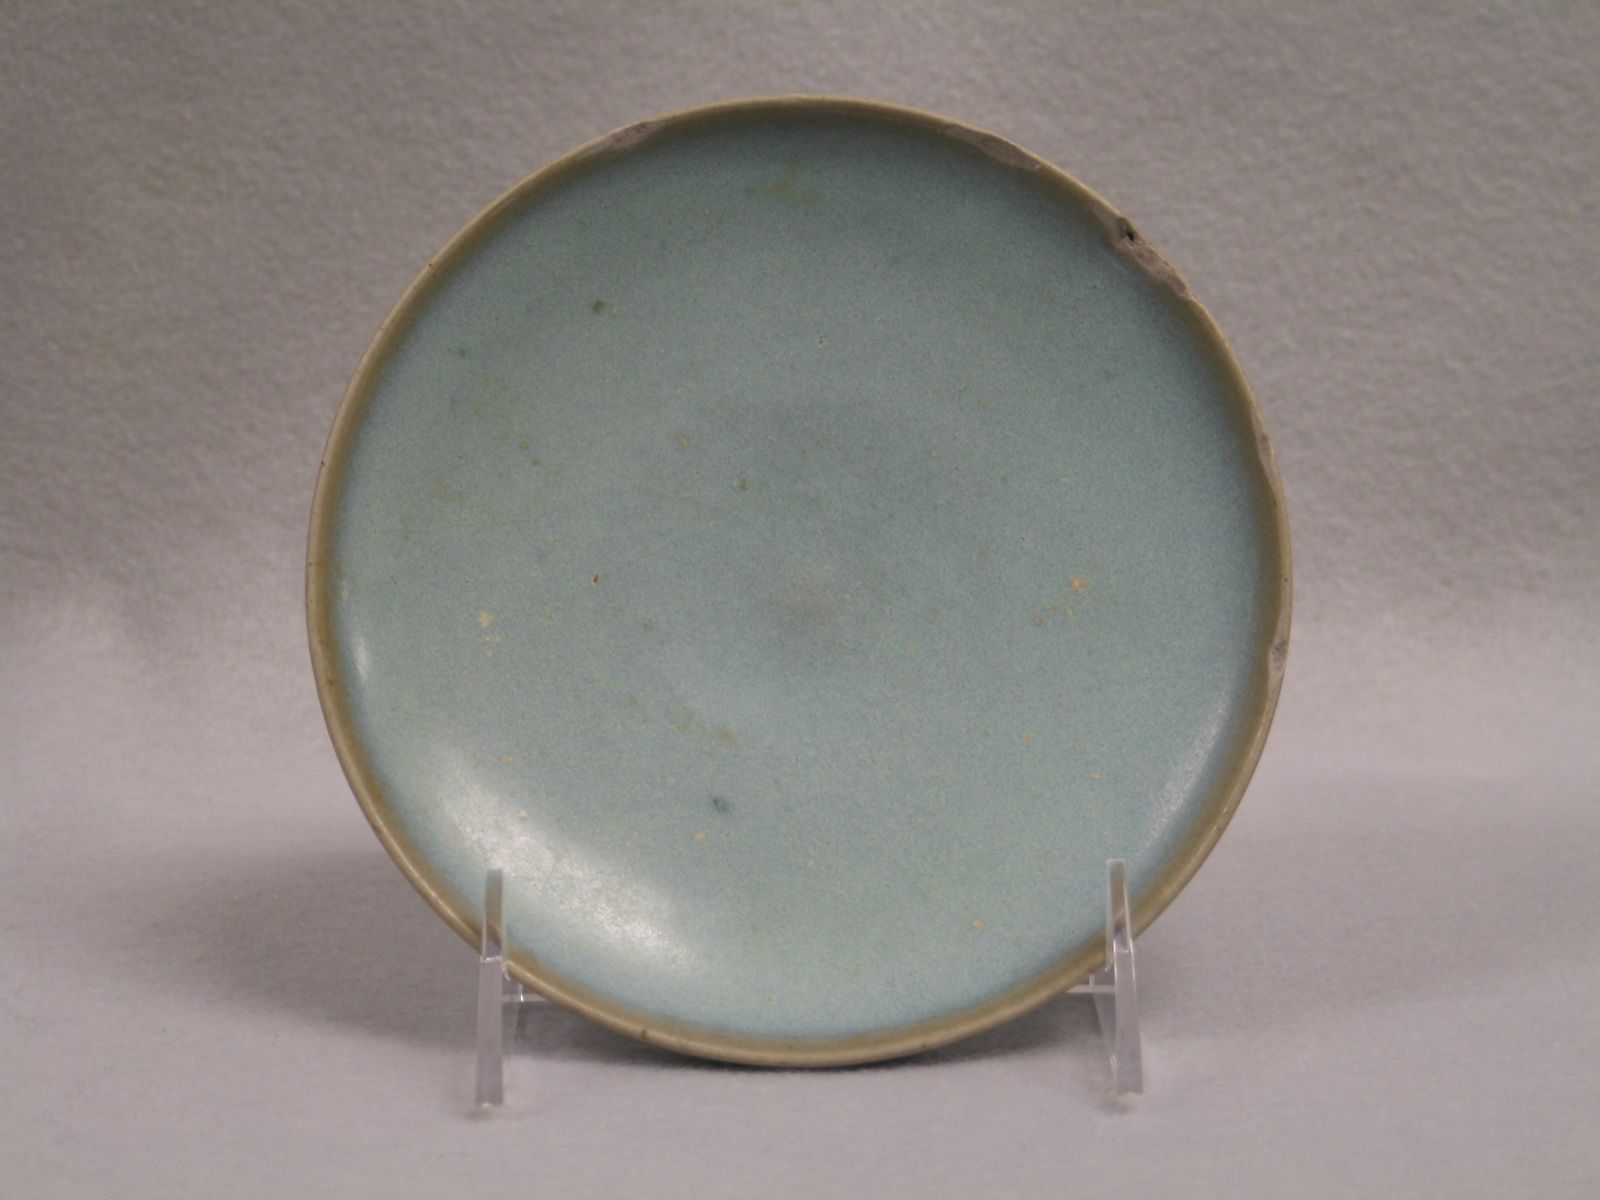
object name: dish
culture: chinese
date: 1101-1300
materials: glaze, stoneware